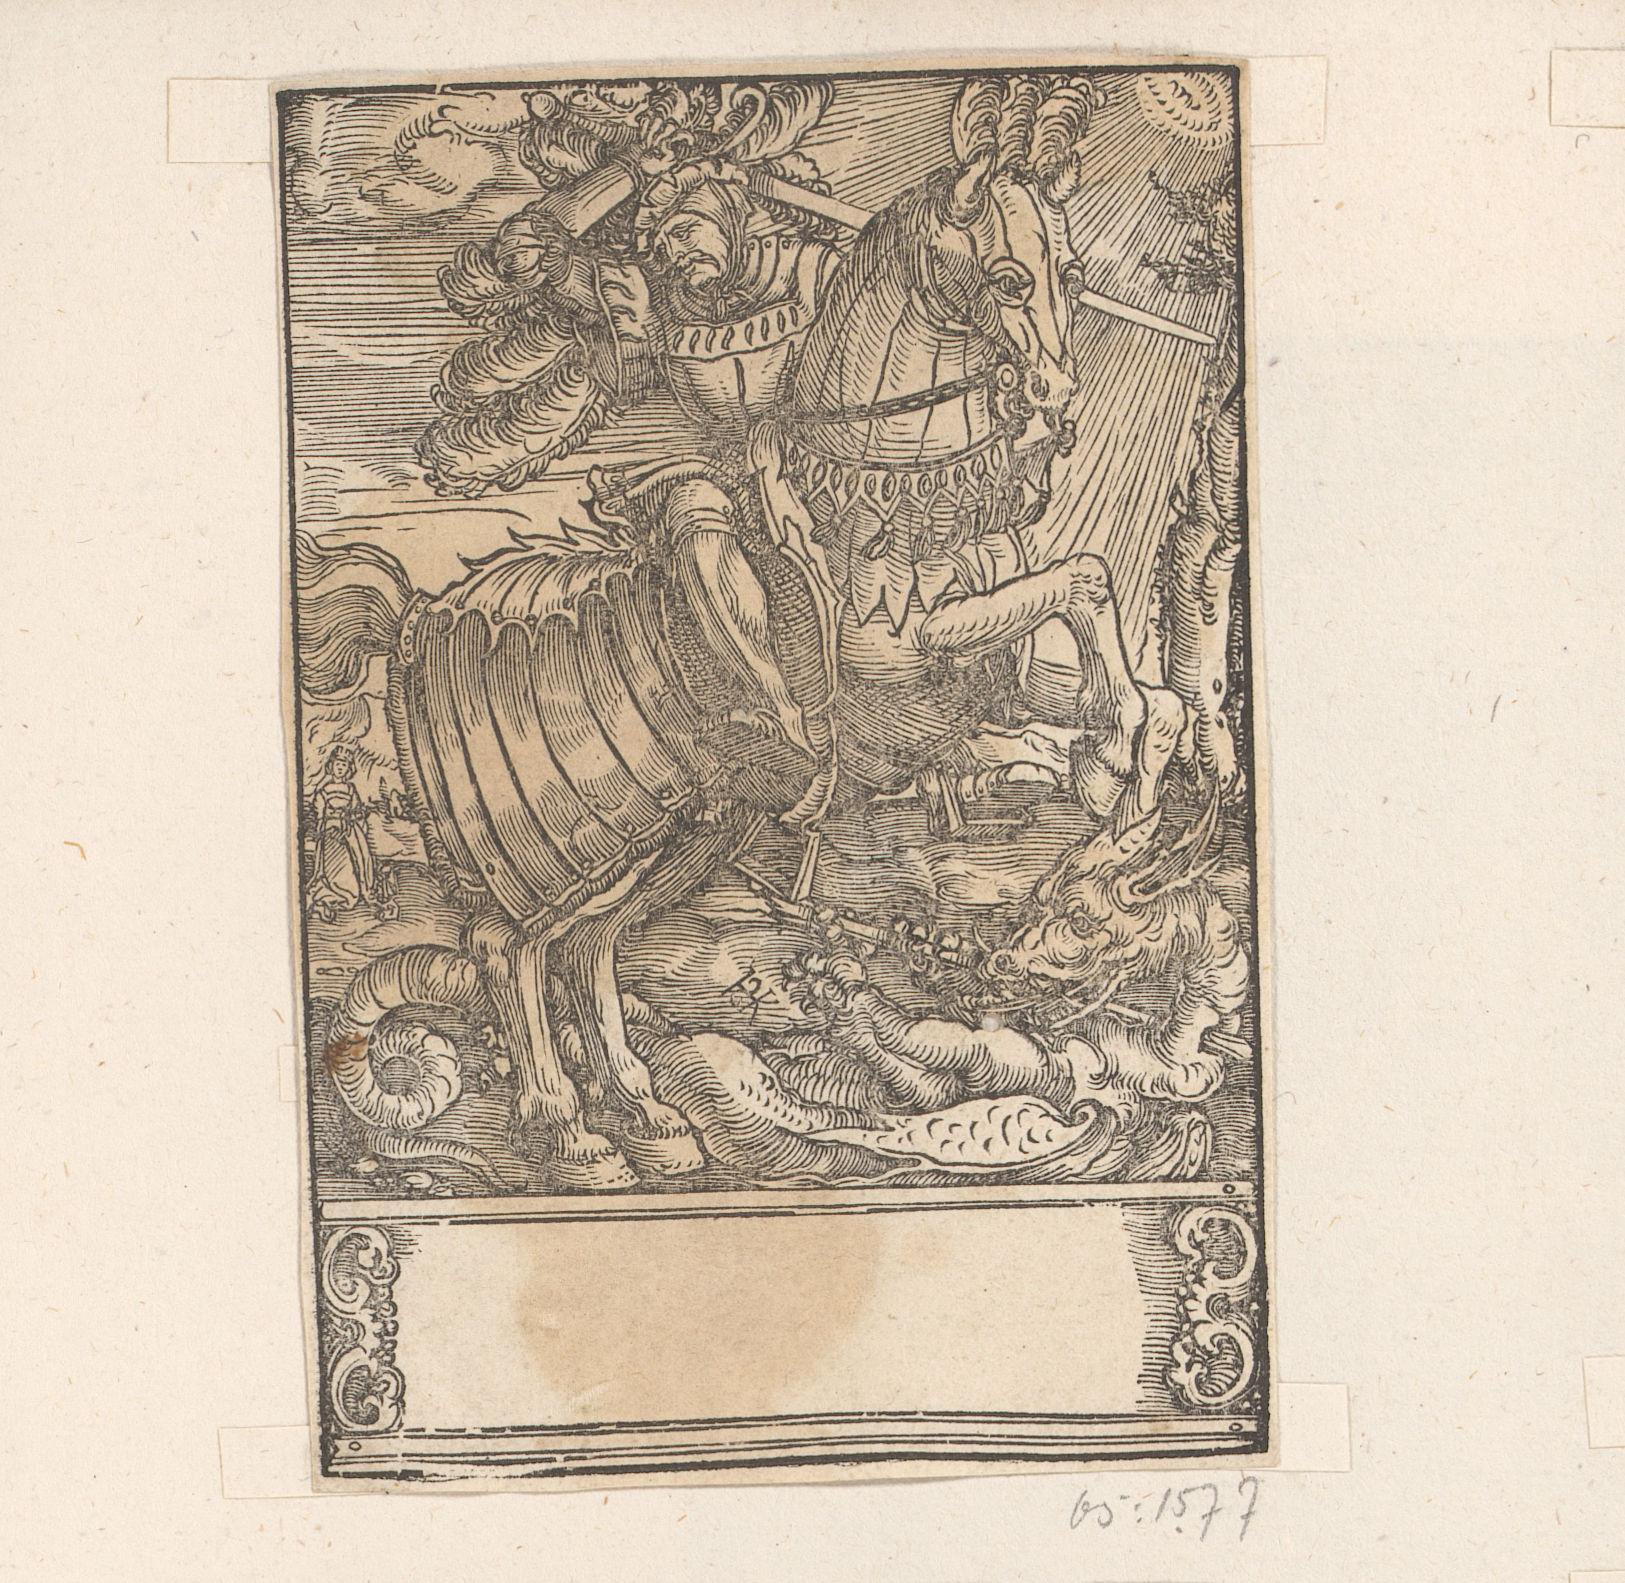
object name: print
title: Hortulus Anime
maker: hans springinklee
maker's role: print maker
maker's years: -1540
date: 1518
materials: paper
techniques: woodcut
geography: nuremberg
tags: st. george and the dragon: dressed in armour and mounted on a (white) horse he brandishes his sword (his lance lies already broken on the ground); the princess nearby may be shown praying or fleeing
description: De heilige Joris zit geharnast te paard en doodt de draak. Links op de achtergrond de prinses. Prent maakt deel uit van een album.